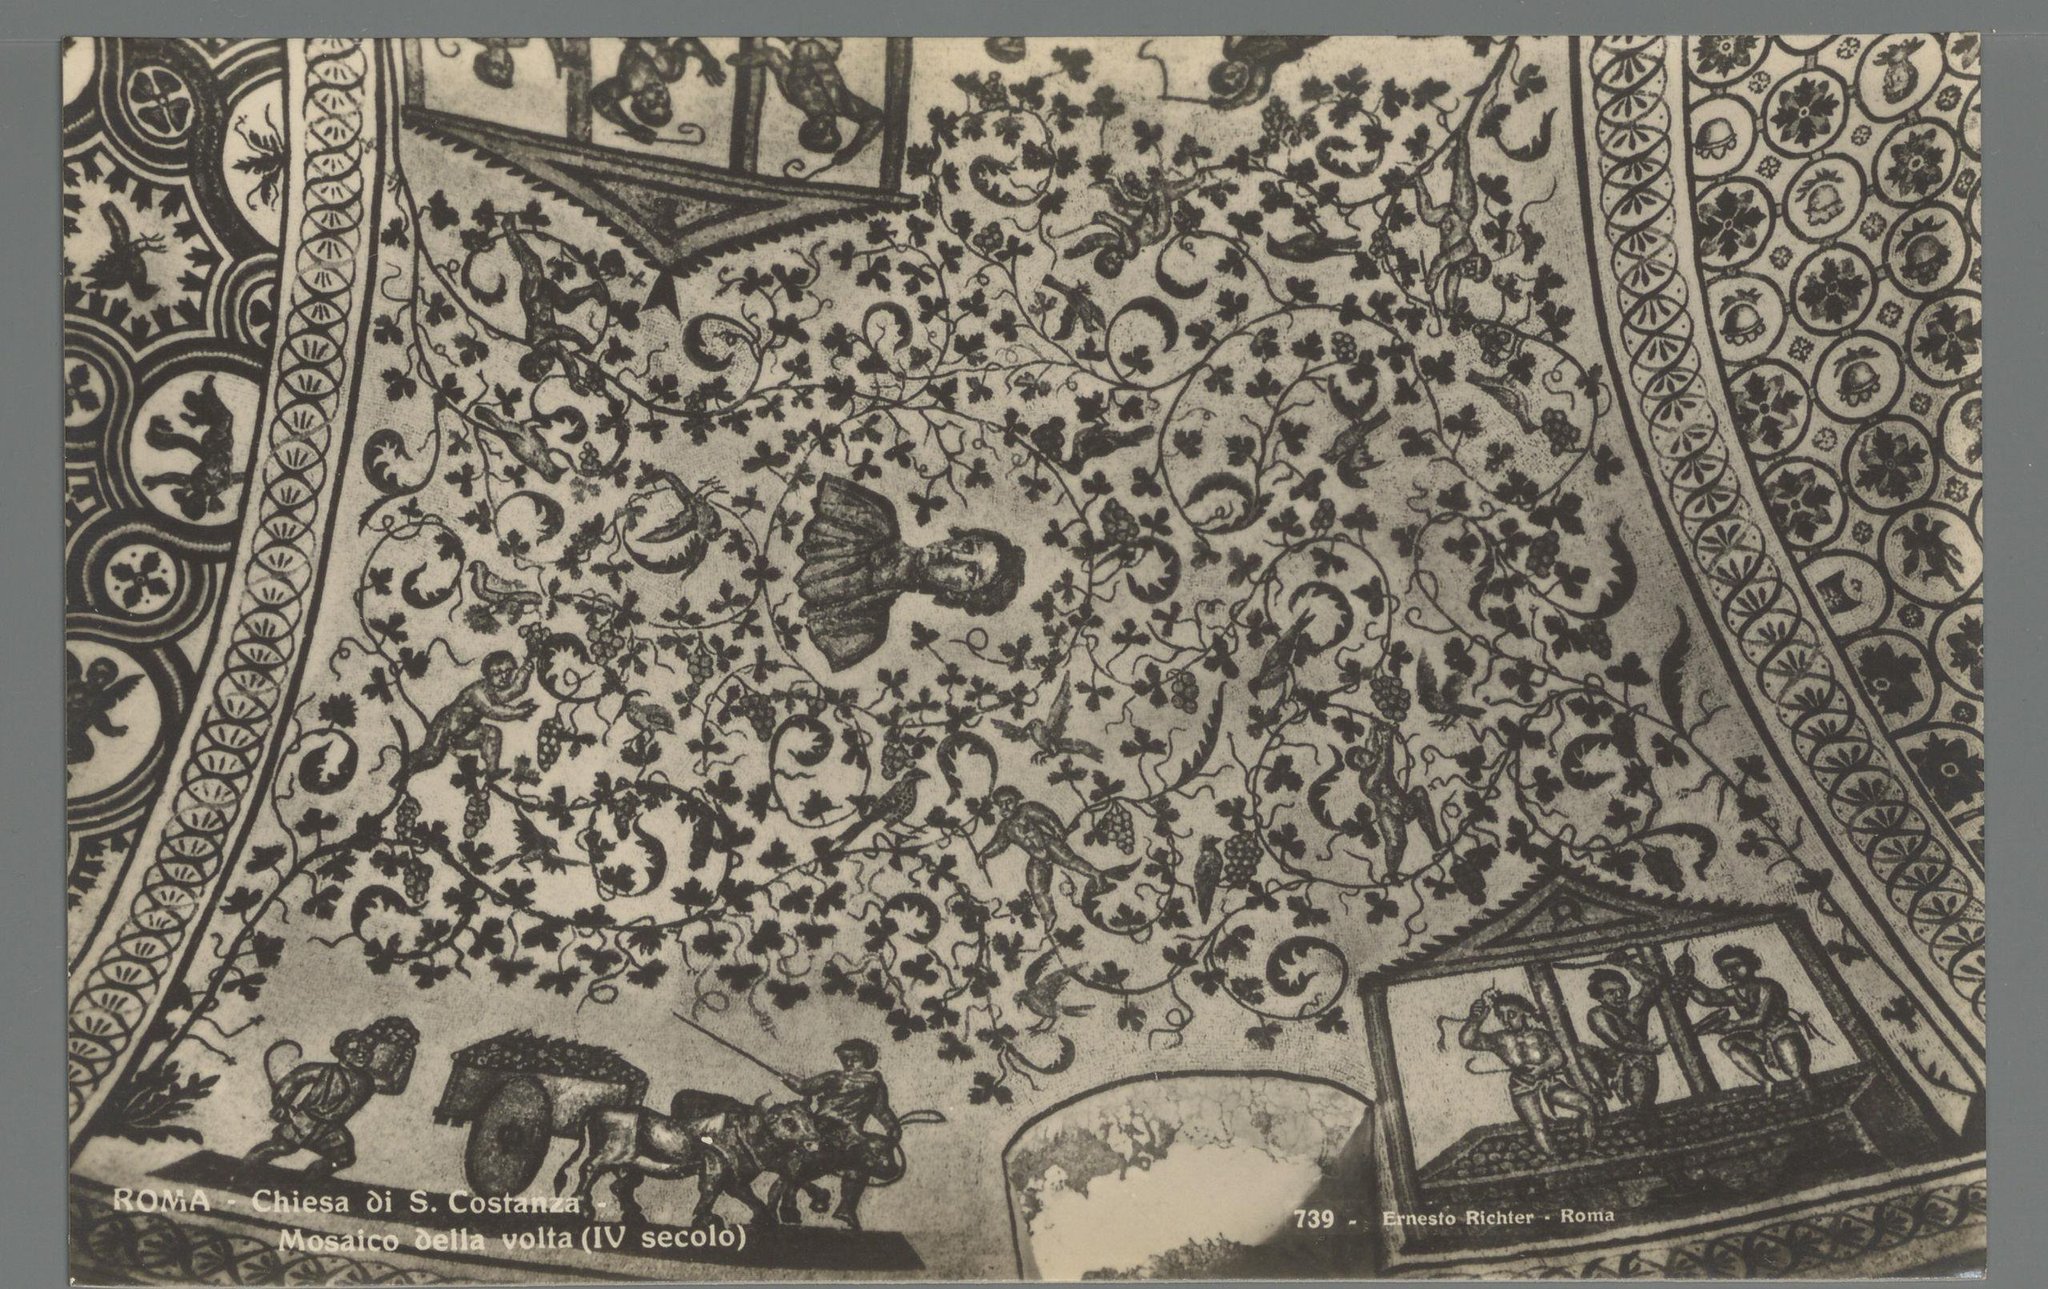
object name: photograph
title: Roma - Chiesa di S. Constanza. Mosaico della volta (IV secolo)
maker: ernesto richter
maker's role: publisher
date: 1906-1930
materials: paper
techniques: gelatin silver print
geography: rome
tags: interior of church, (decorated) ceiling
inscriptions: collector's mark: ‘AFE v S’